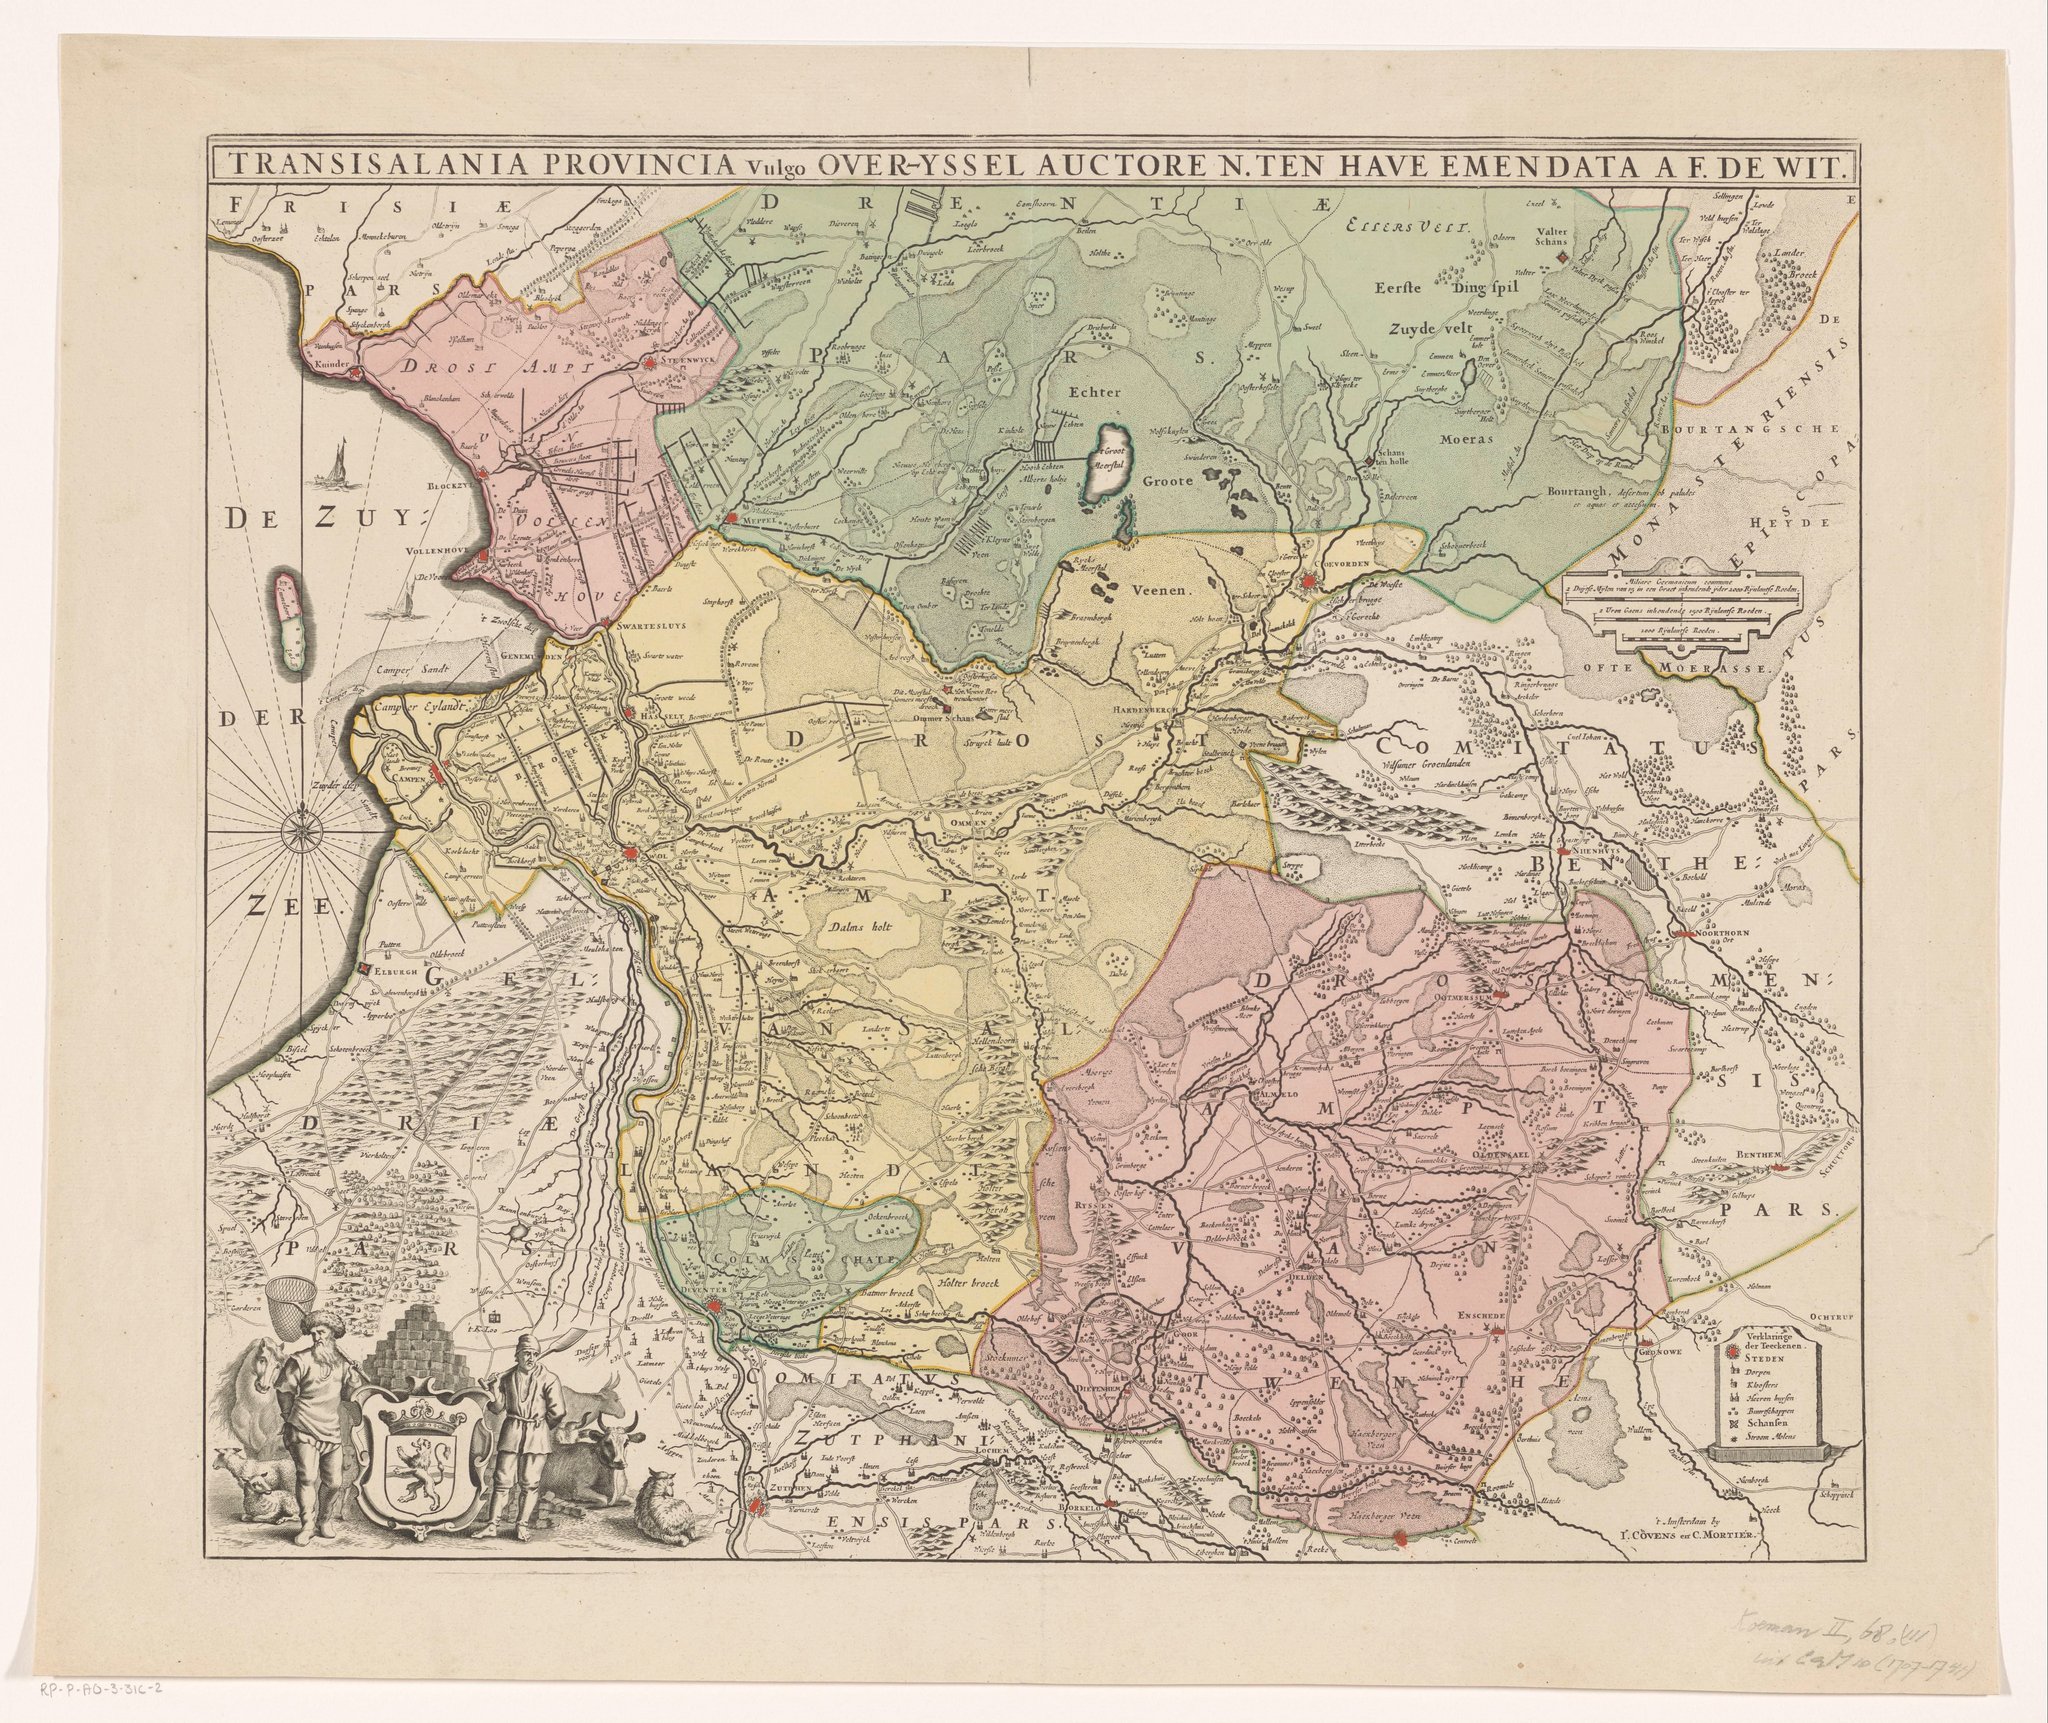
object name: print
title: Transisalania provincia vulgo Over-yssel (...)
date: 1721-1774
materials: paper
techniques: engraving, etching, hand coloring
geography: amsterdam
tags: coat of arms (as symbol of the state, etc.), peat-cutting, maps of separate countries or regions, cattle, fisherman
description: Linksonder een cartouche met het wapen van Overijssel, daaromheen een visser en een turfsteker, turf en vee. Rechtsboven drie schaalstokken: Miliare Germanicum commune / 2 Duijtse mijlen van 15 in een graet inhoudende ijder 2000 Rijnlantse roeden, 2 uren gaens inhoudende 1500 Rijnlantse roeden, 2000 Rijnlantse roeden. Rechtsonder een legenda.